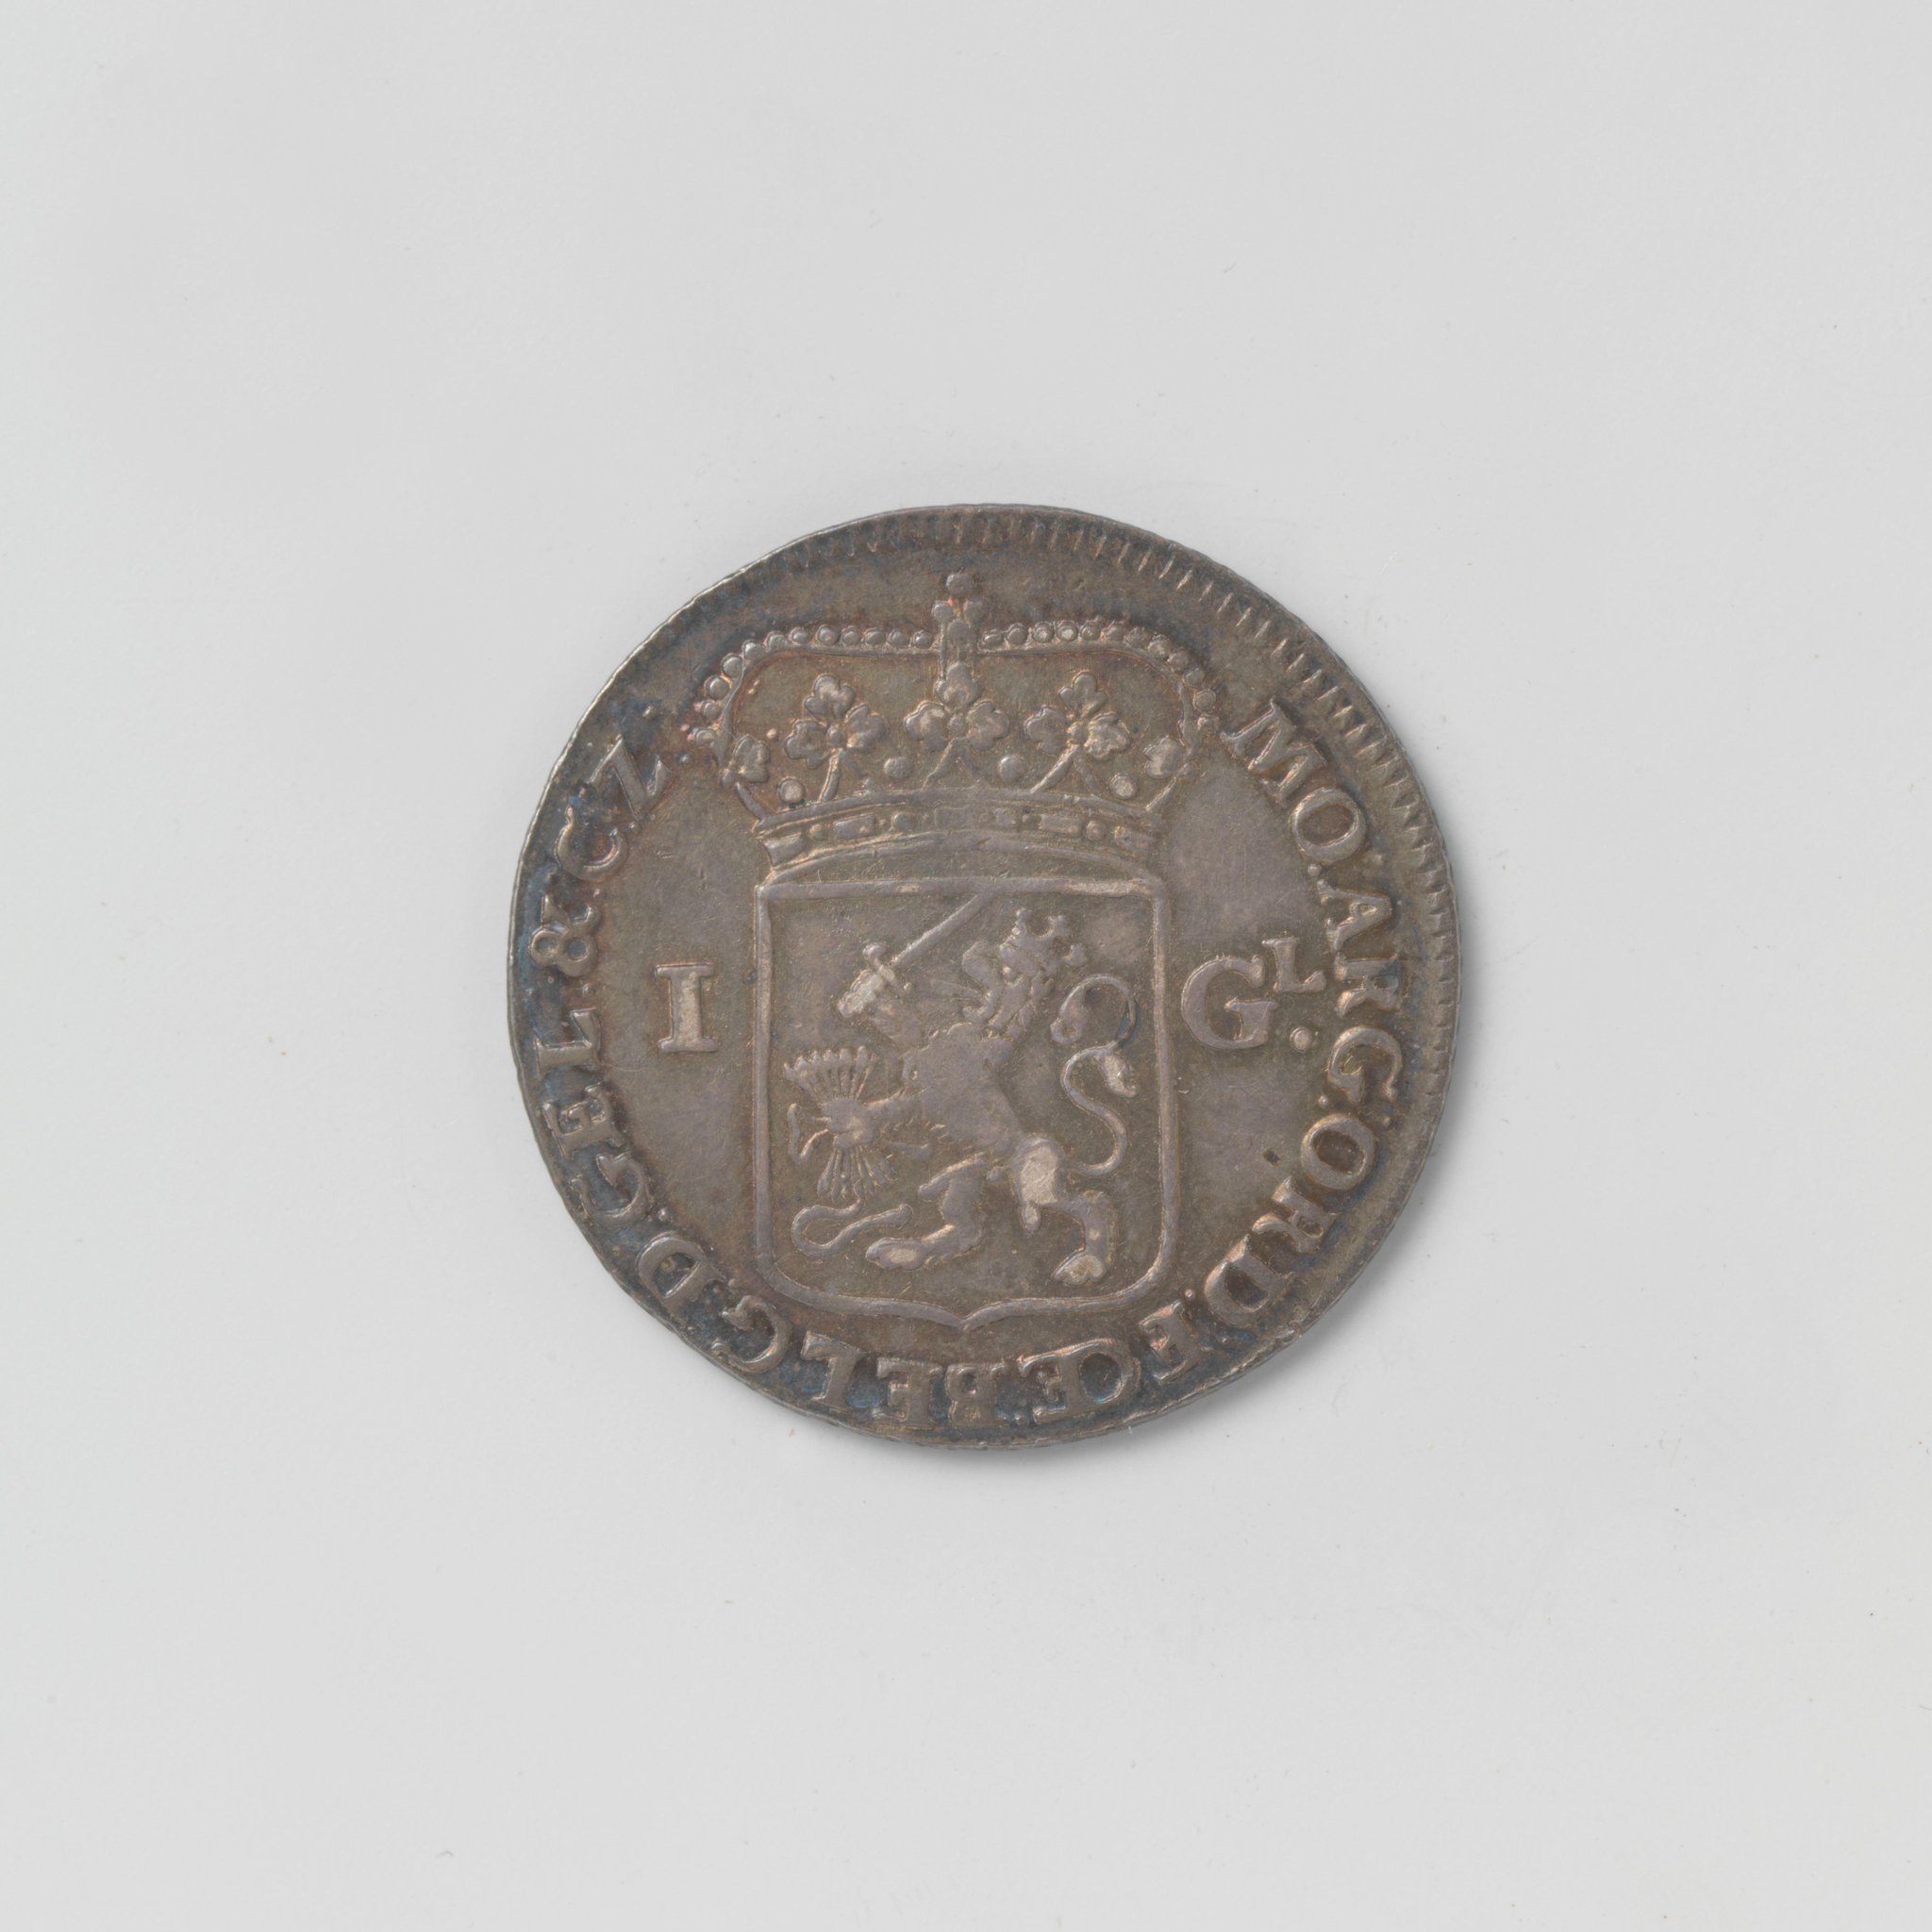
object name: coin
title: Gelderse gulden, 1763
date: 1763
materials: silver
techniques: striking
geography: harderwijk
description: Zilveren munt. Voorzijde: tussen waarde-aanduiding gekroond generaliteitswapenschild. Keerzijde: staande Nederlandse maagd, in rechterhand lans met hoed, met linkerhand steunend op pilaar, waarop bijbel. In afsnede jaartal.